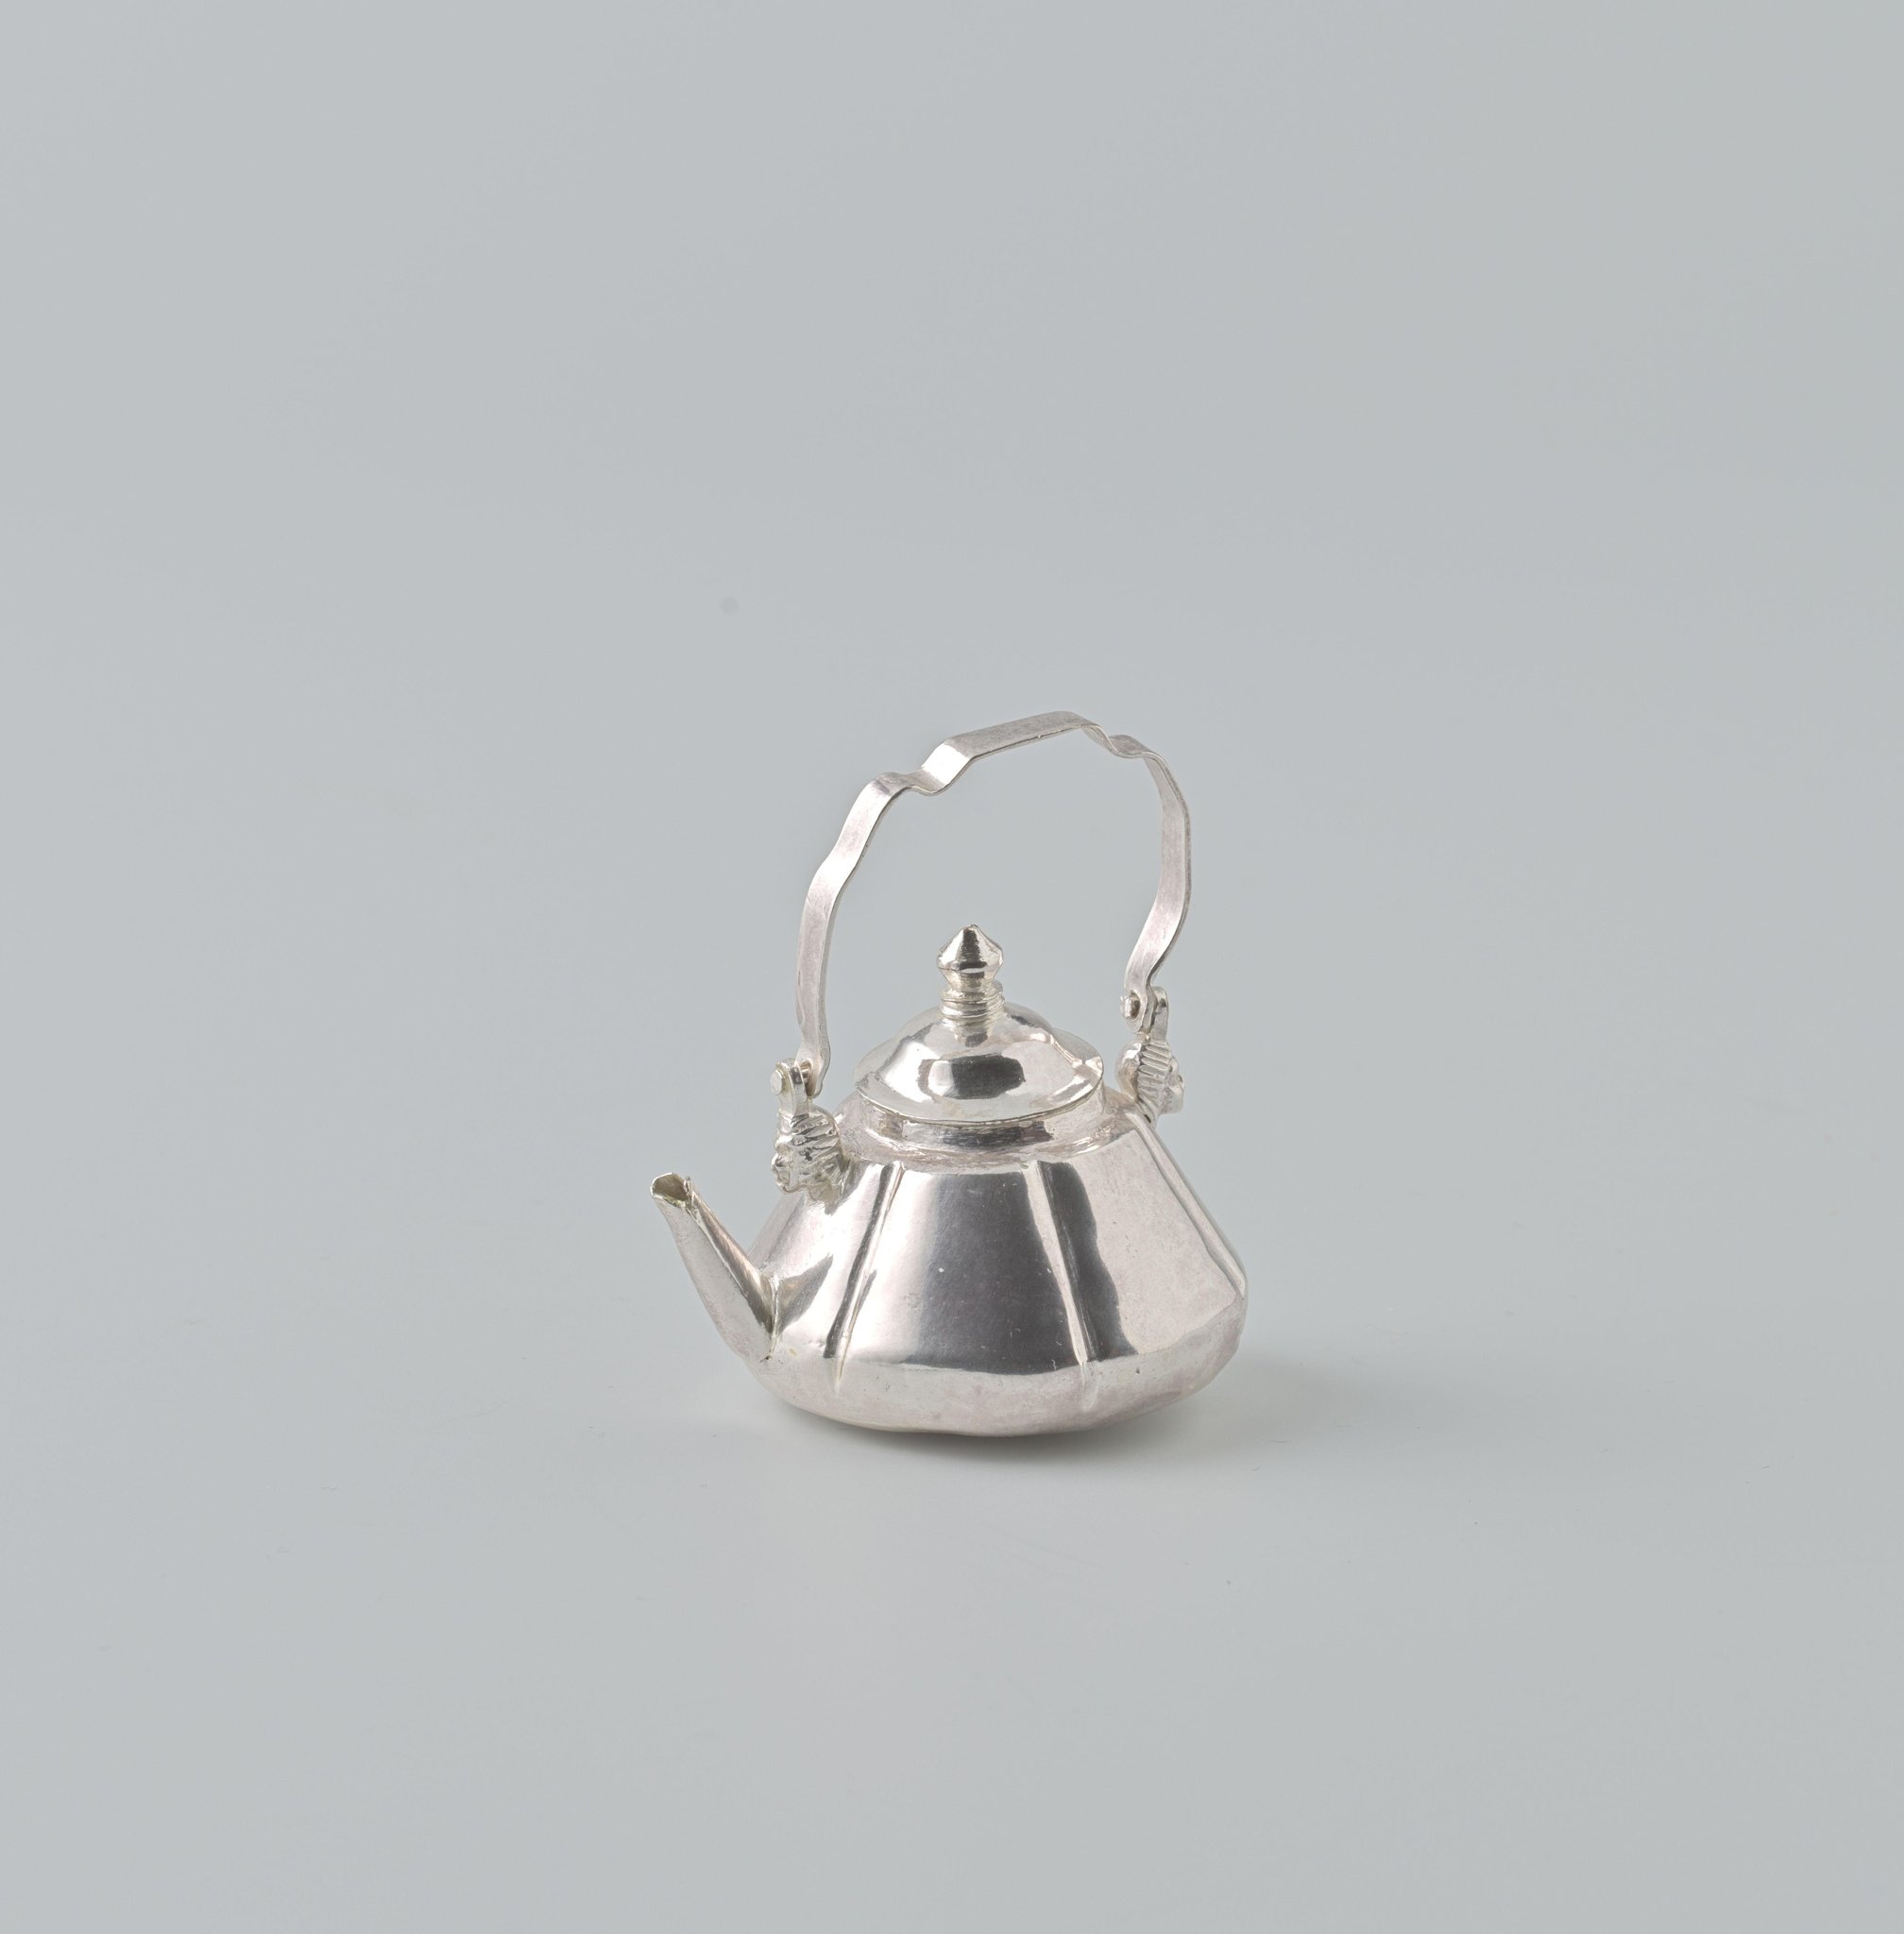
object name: teakettle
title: Waterketel van zilver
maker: Anonymous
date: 1675-1700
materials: silver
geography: amsterdam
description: 1 Confoor voor de Theketel in de beste kamer.